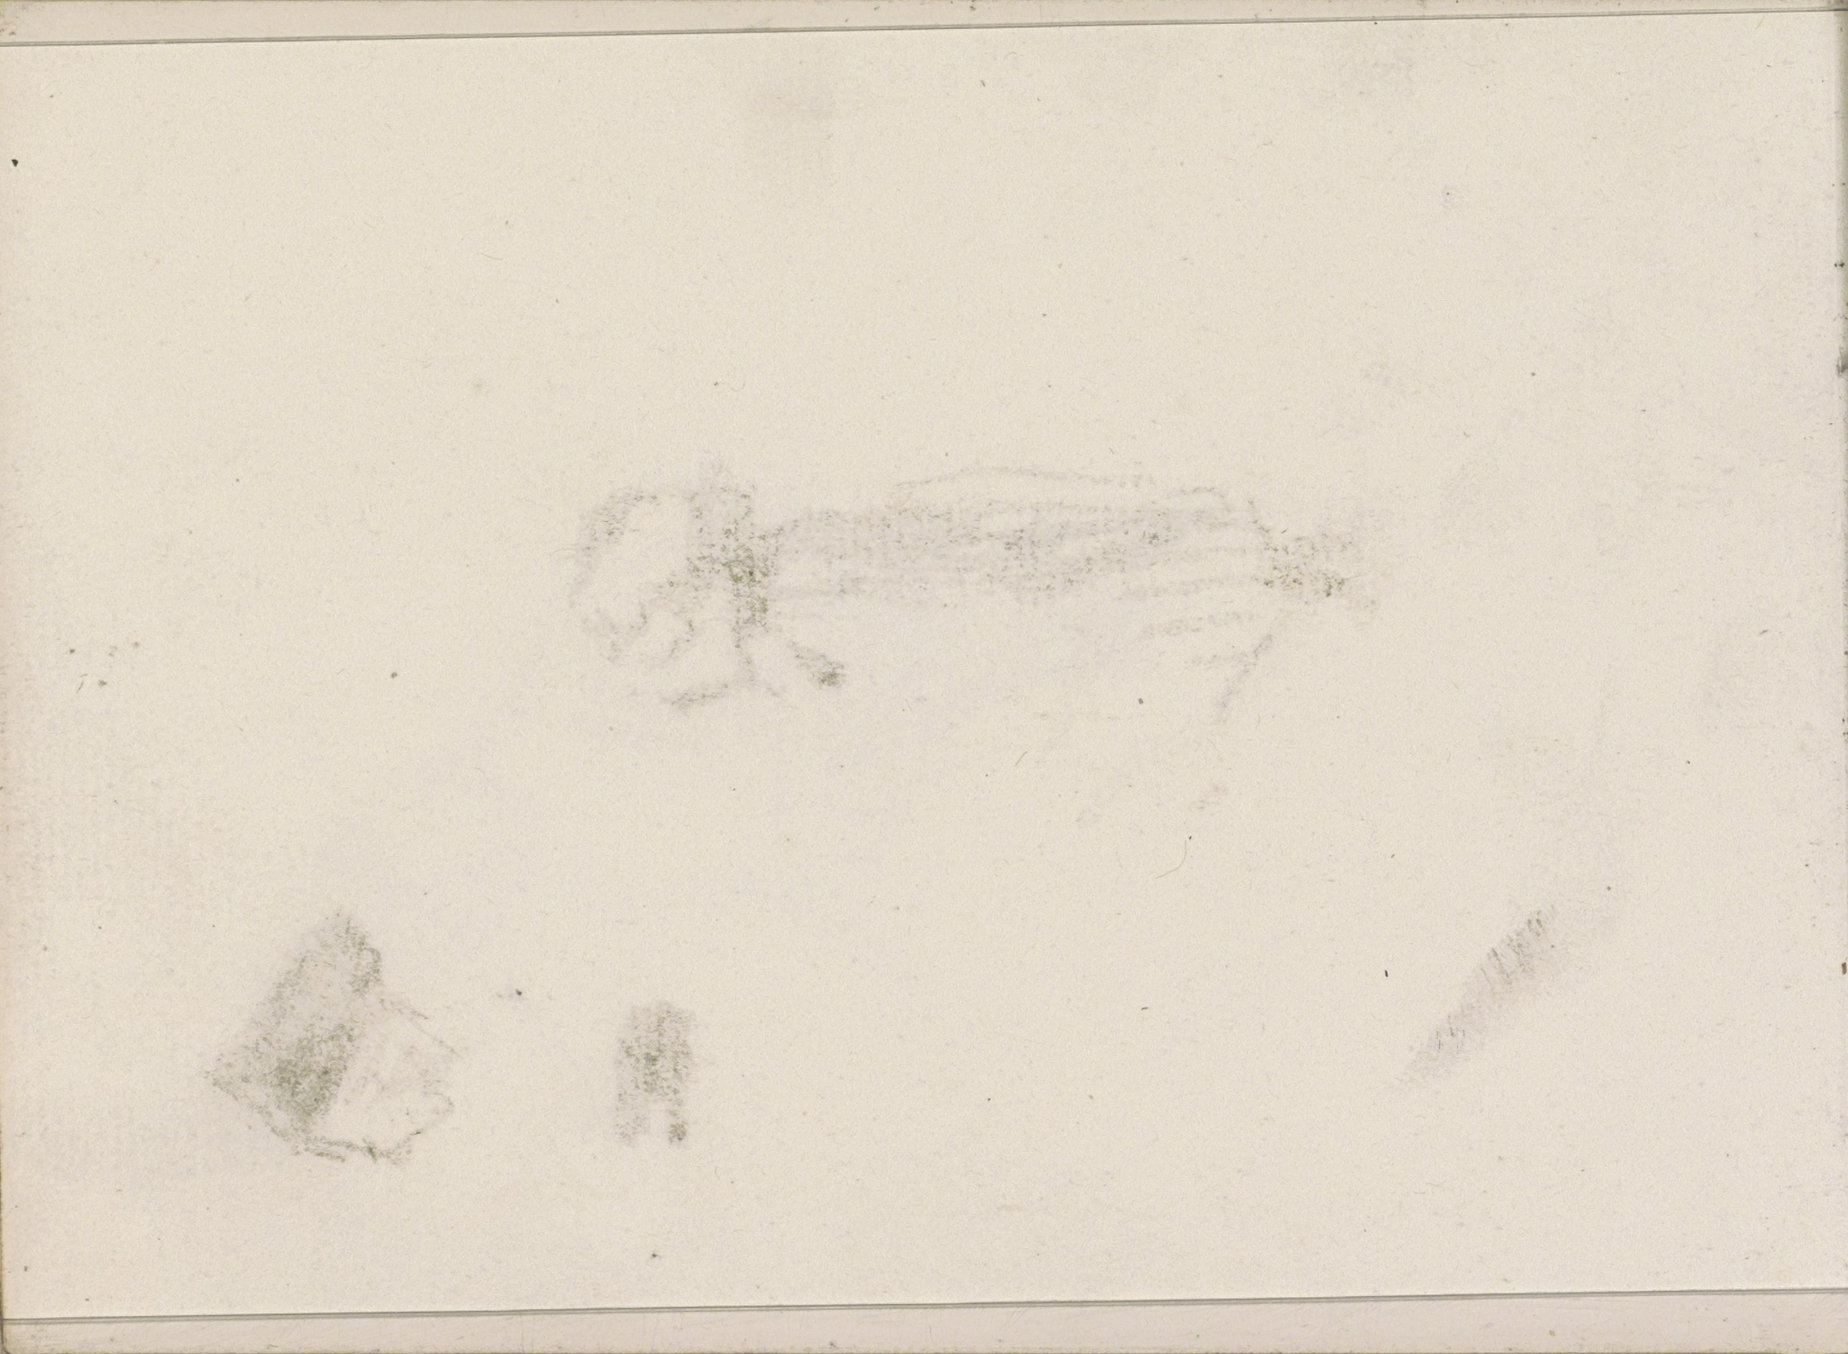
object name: sketchbook leaf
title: Abklatsch van de krijttekening op pagina 45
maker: isaac israels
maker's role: draughtsman, painter, print maker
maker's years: 1865-1934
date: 1886-1903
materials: paper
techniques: printmaking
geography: amsterdam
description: Pagina 44 uit schetsboek XLVII met 52 pagina's.